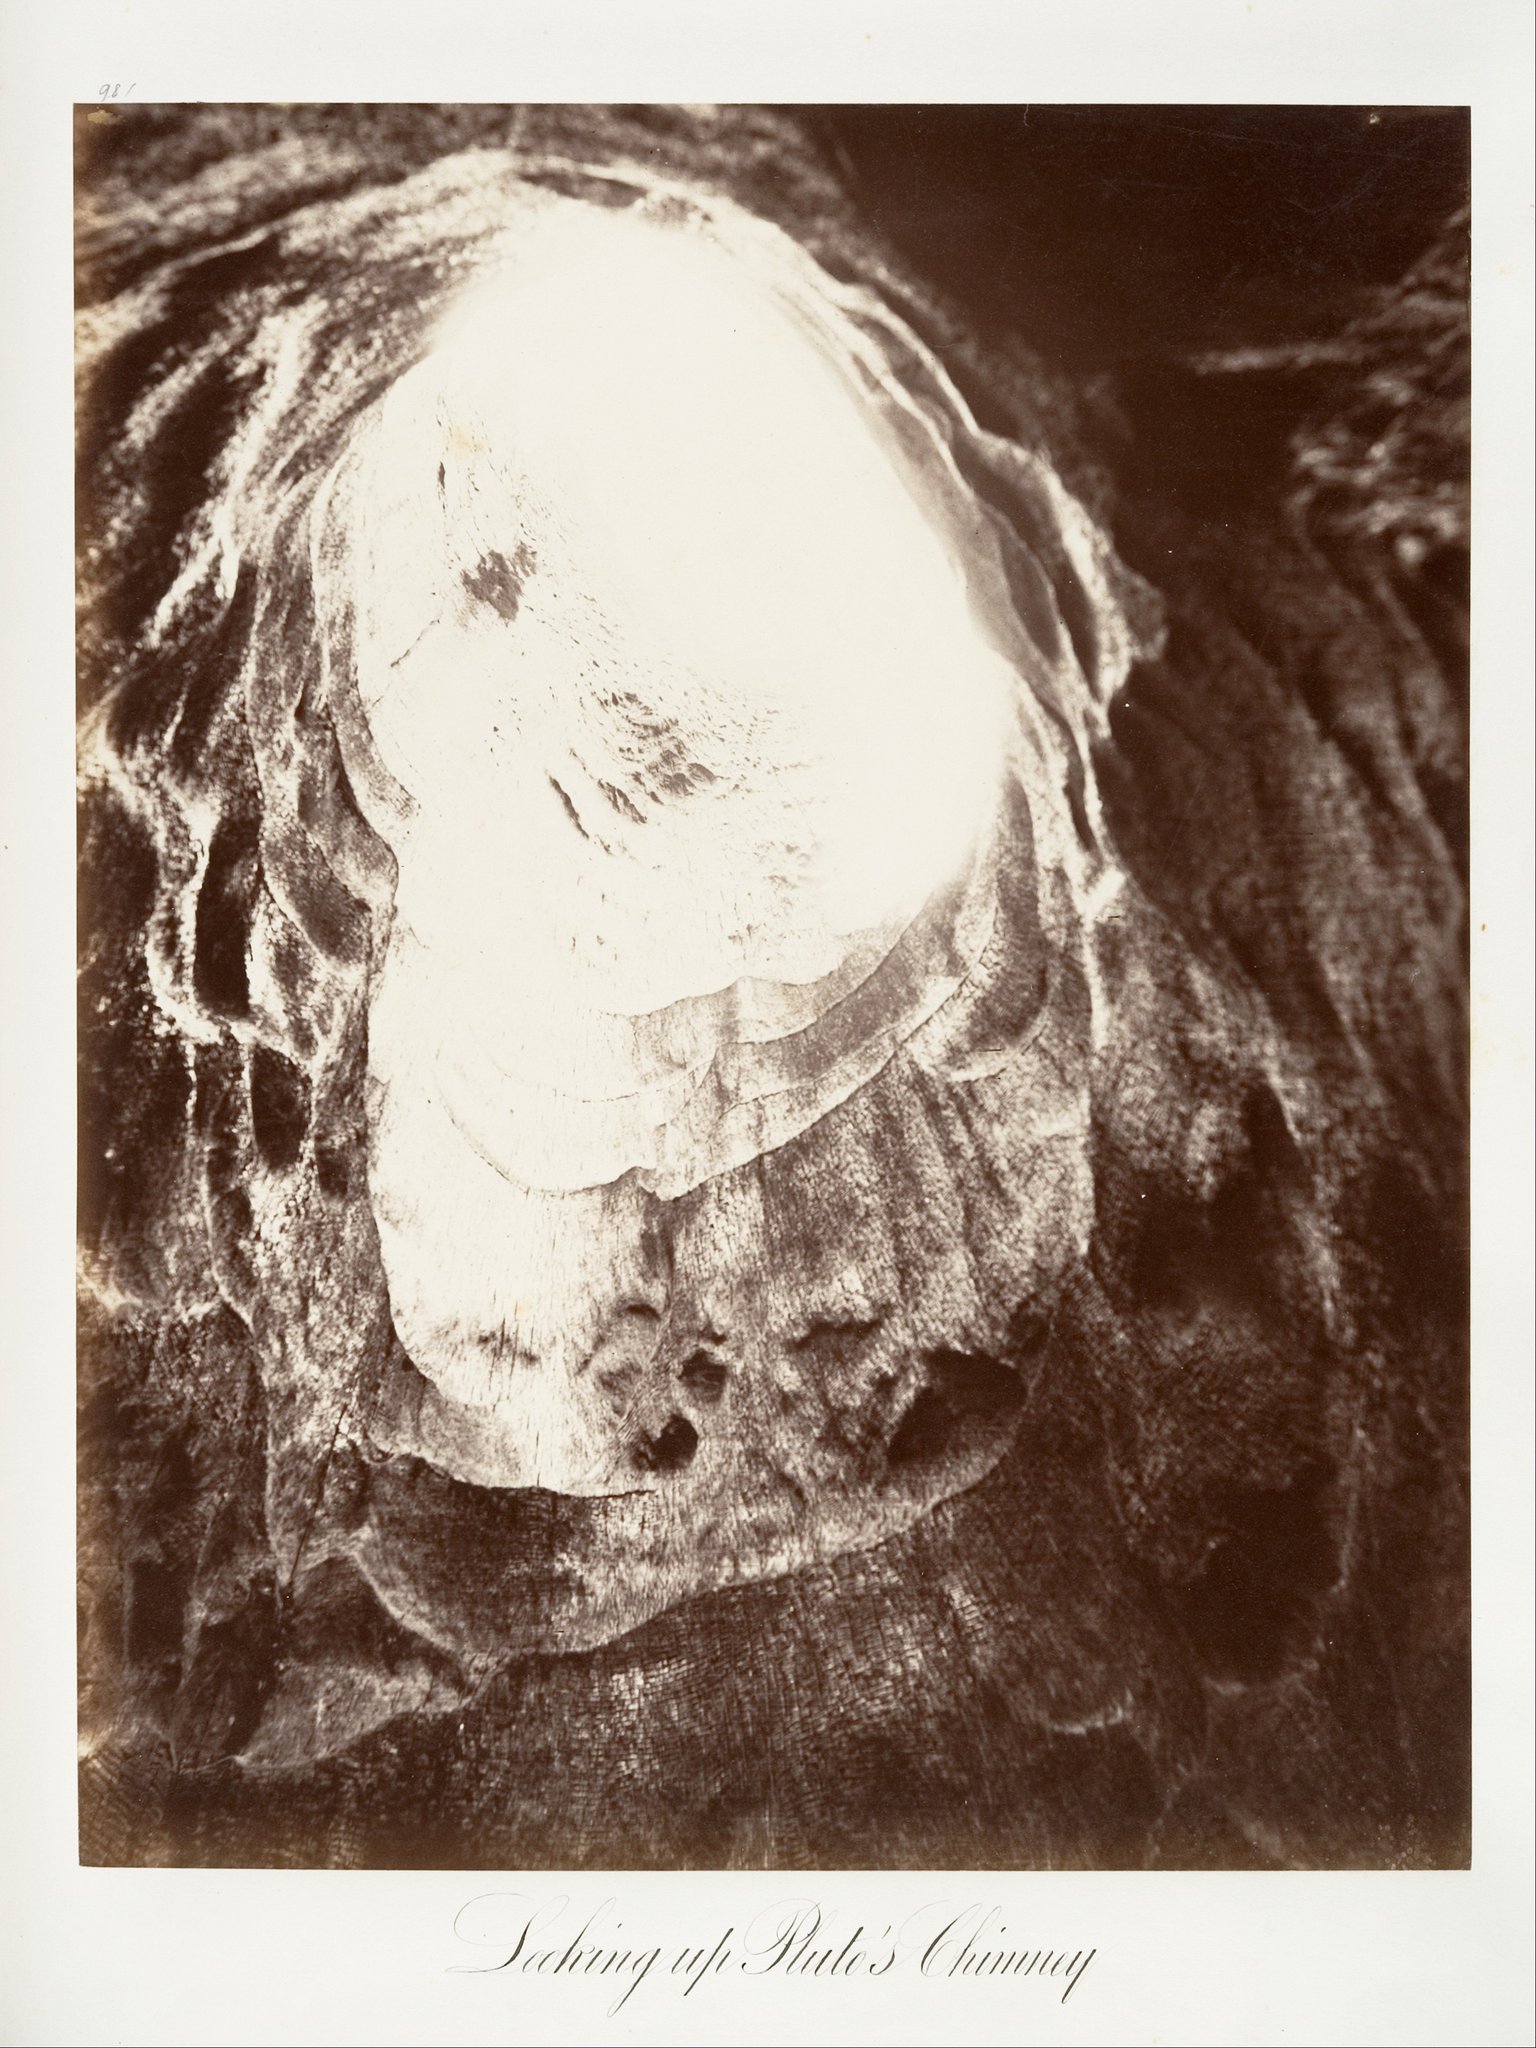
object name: photograph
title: Looking Up Pluto's Chimney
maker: carleton e. watkins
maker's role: artist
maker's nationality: american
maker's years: 1829-1916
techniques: albumen silver print, glass negative